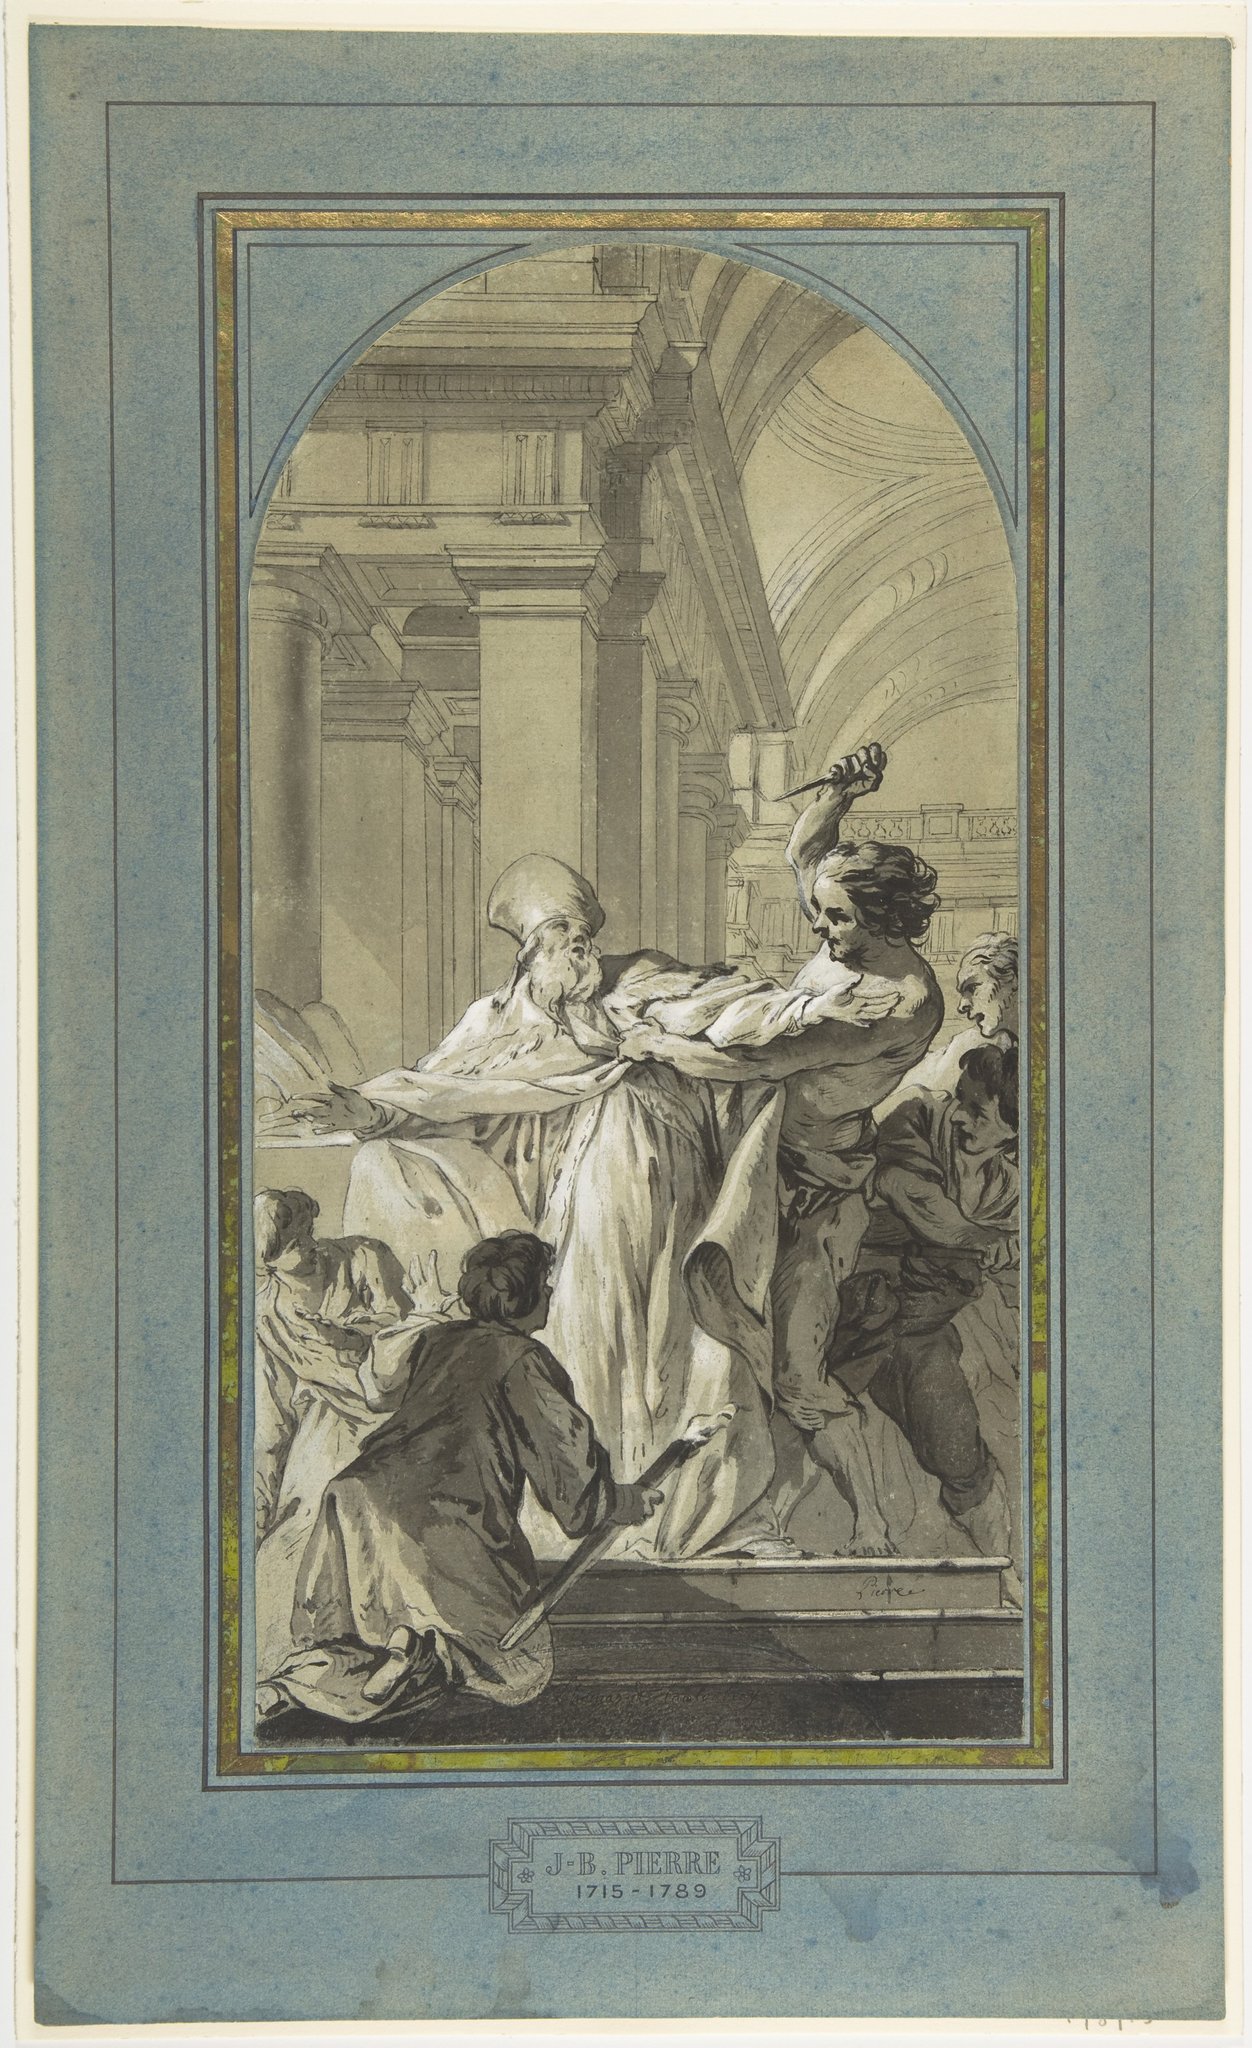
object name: drawing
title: The Martyrdom of St. Thomas Becket, Archbishop of Canterbury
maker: jean-baptiste marie pierre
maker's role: artist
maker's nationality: french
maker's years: 1714-1789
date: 1748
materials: chalk, ink, paper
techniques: brush, heightening, pen, wash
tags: weapons,men,saints